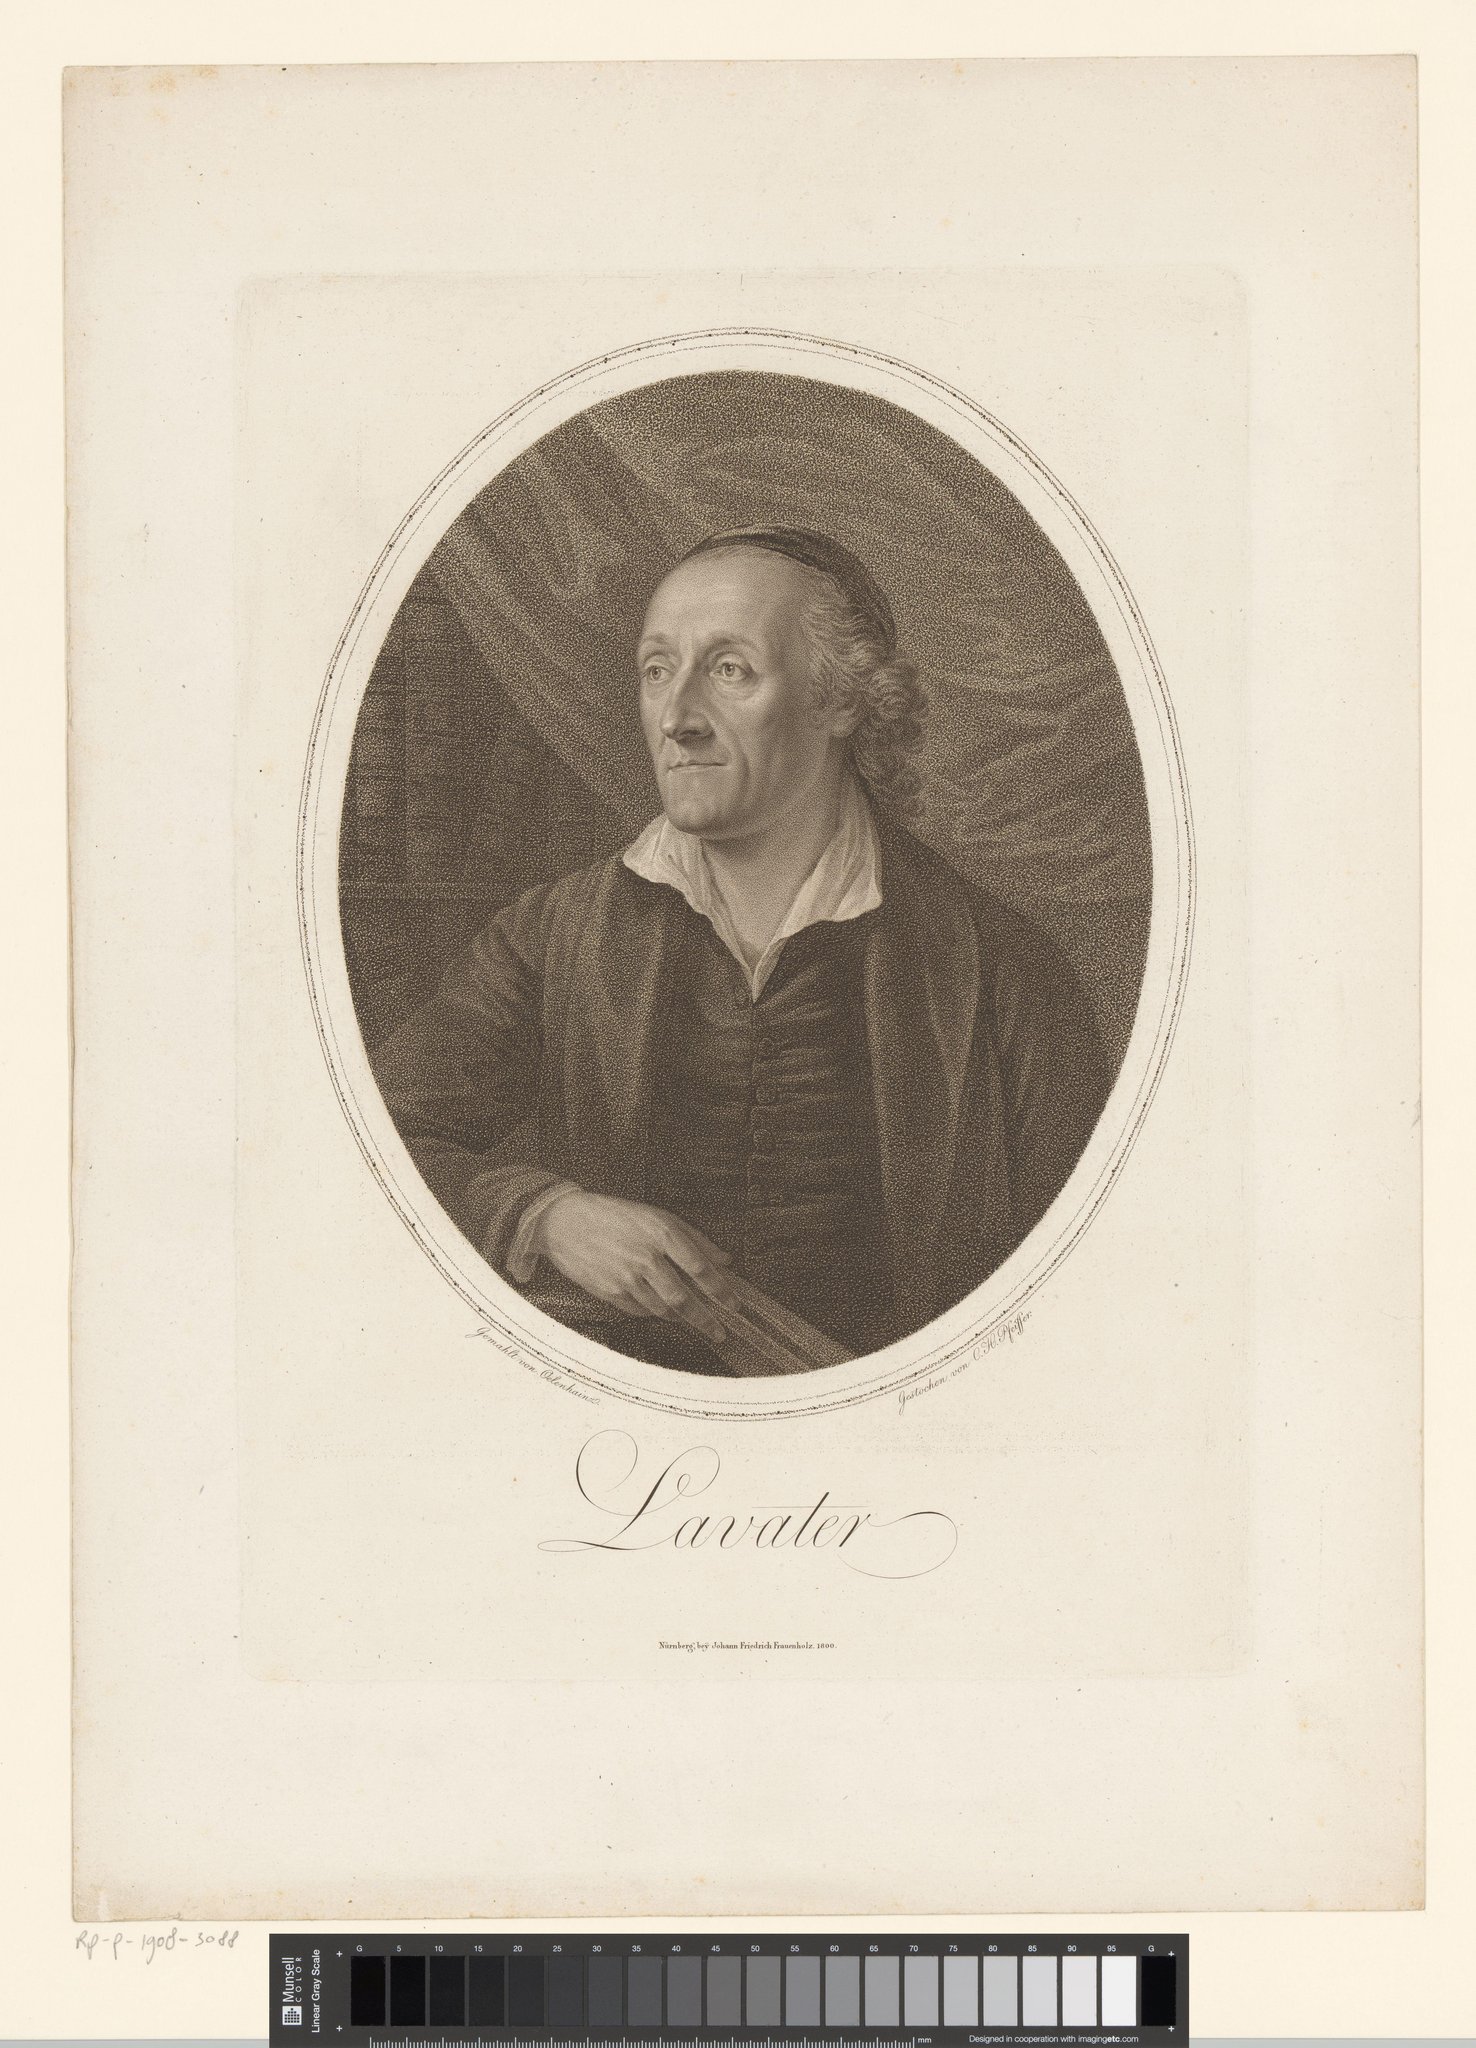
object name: print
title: Portret van Johann Kaspar Lavater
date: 1800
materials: paper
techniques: engraving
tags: johann caspar lavater, bookshelves, historical persons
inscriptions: collector's mark: Lugt 2228, mark: Lugt 994